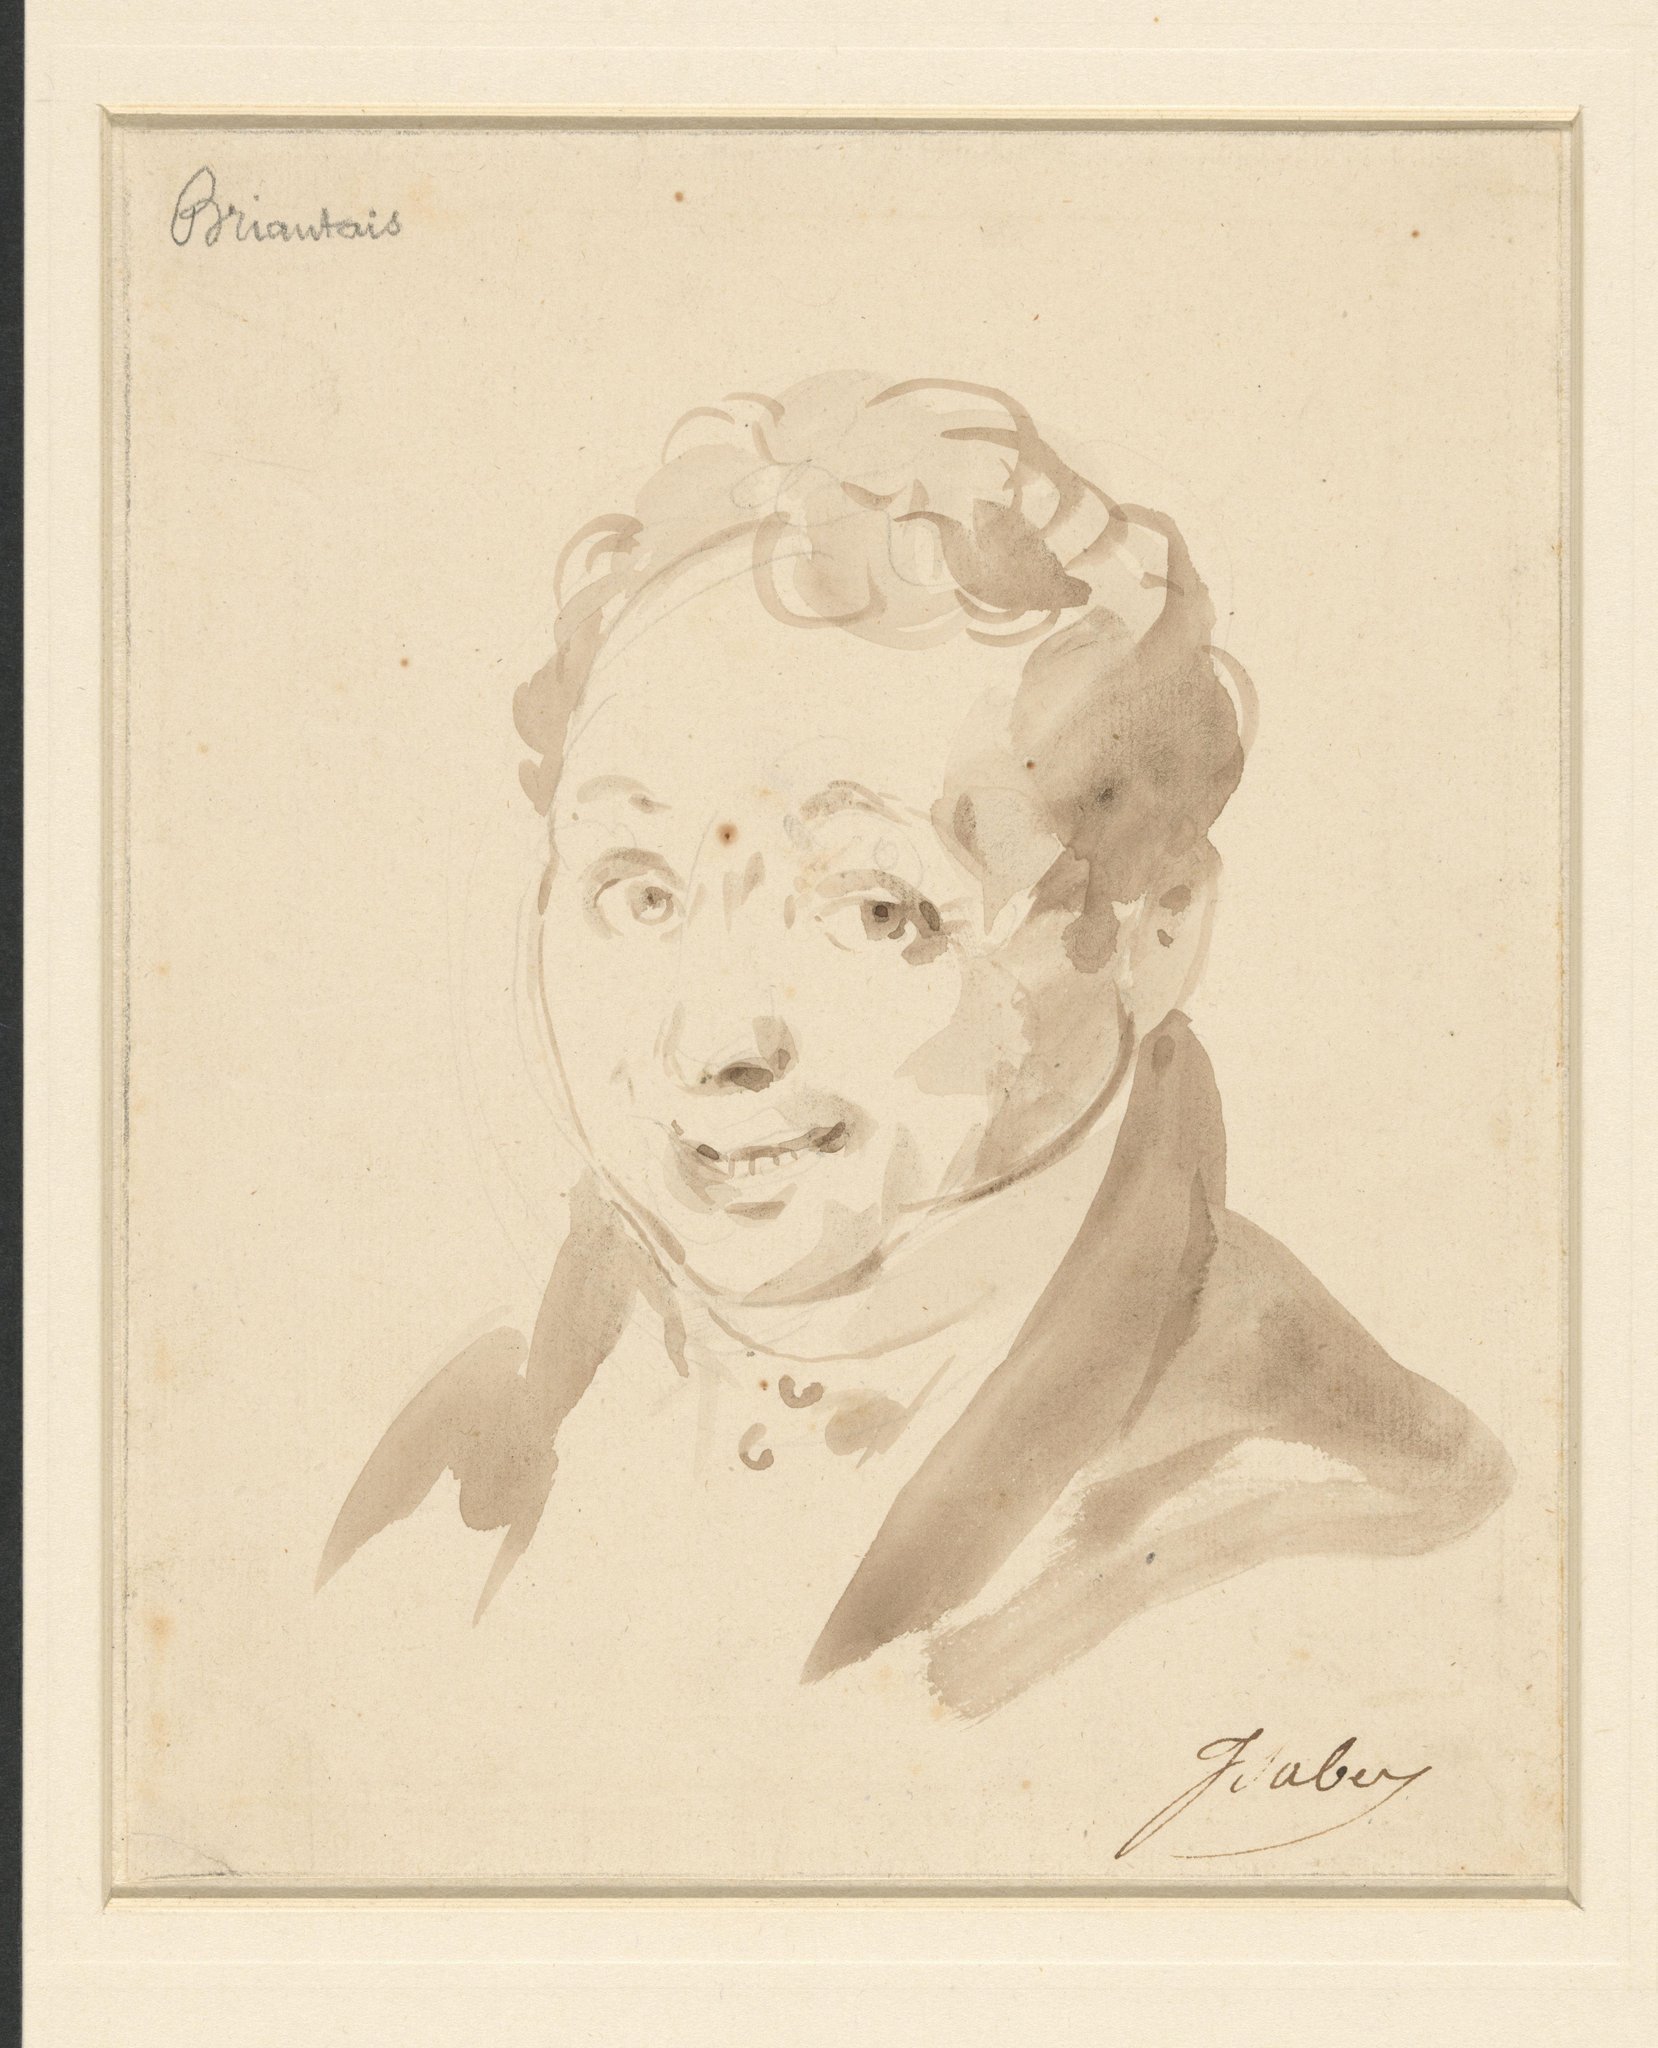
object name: drawing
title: Portret-karikatuur van Briantais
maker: jean baptiste isabey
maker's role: draughtsman, print maker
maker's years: 1767-1855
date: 1777-1855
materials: paper, pencil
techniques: brush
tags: caricatures (human types), historical persons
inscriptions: signature, recto, lower right, pen and brown ink: ‘Isabey’, annotation, recto, upper left, pencil: ‘Briantais’, collector's mark, verso, lower left: Lugt 2228